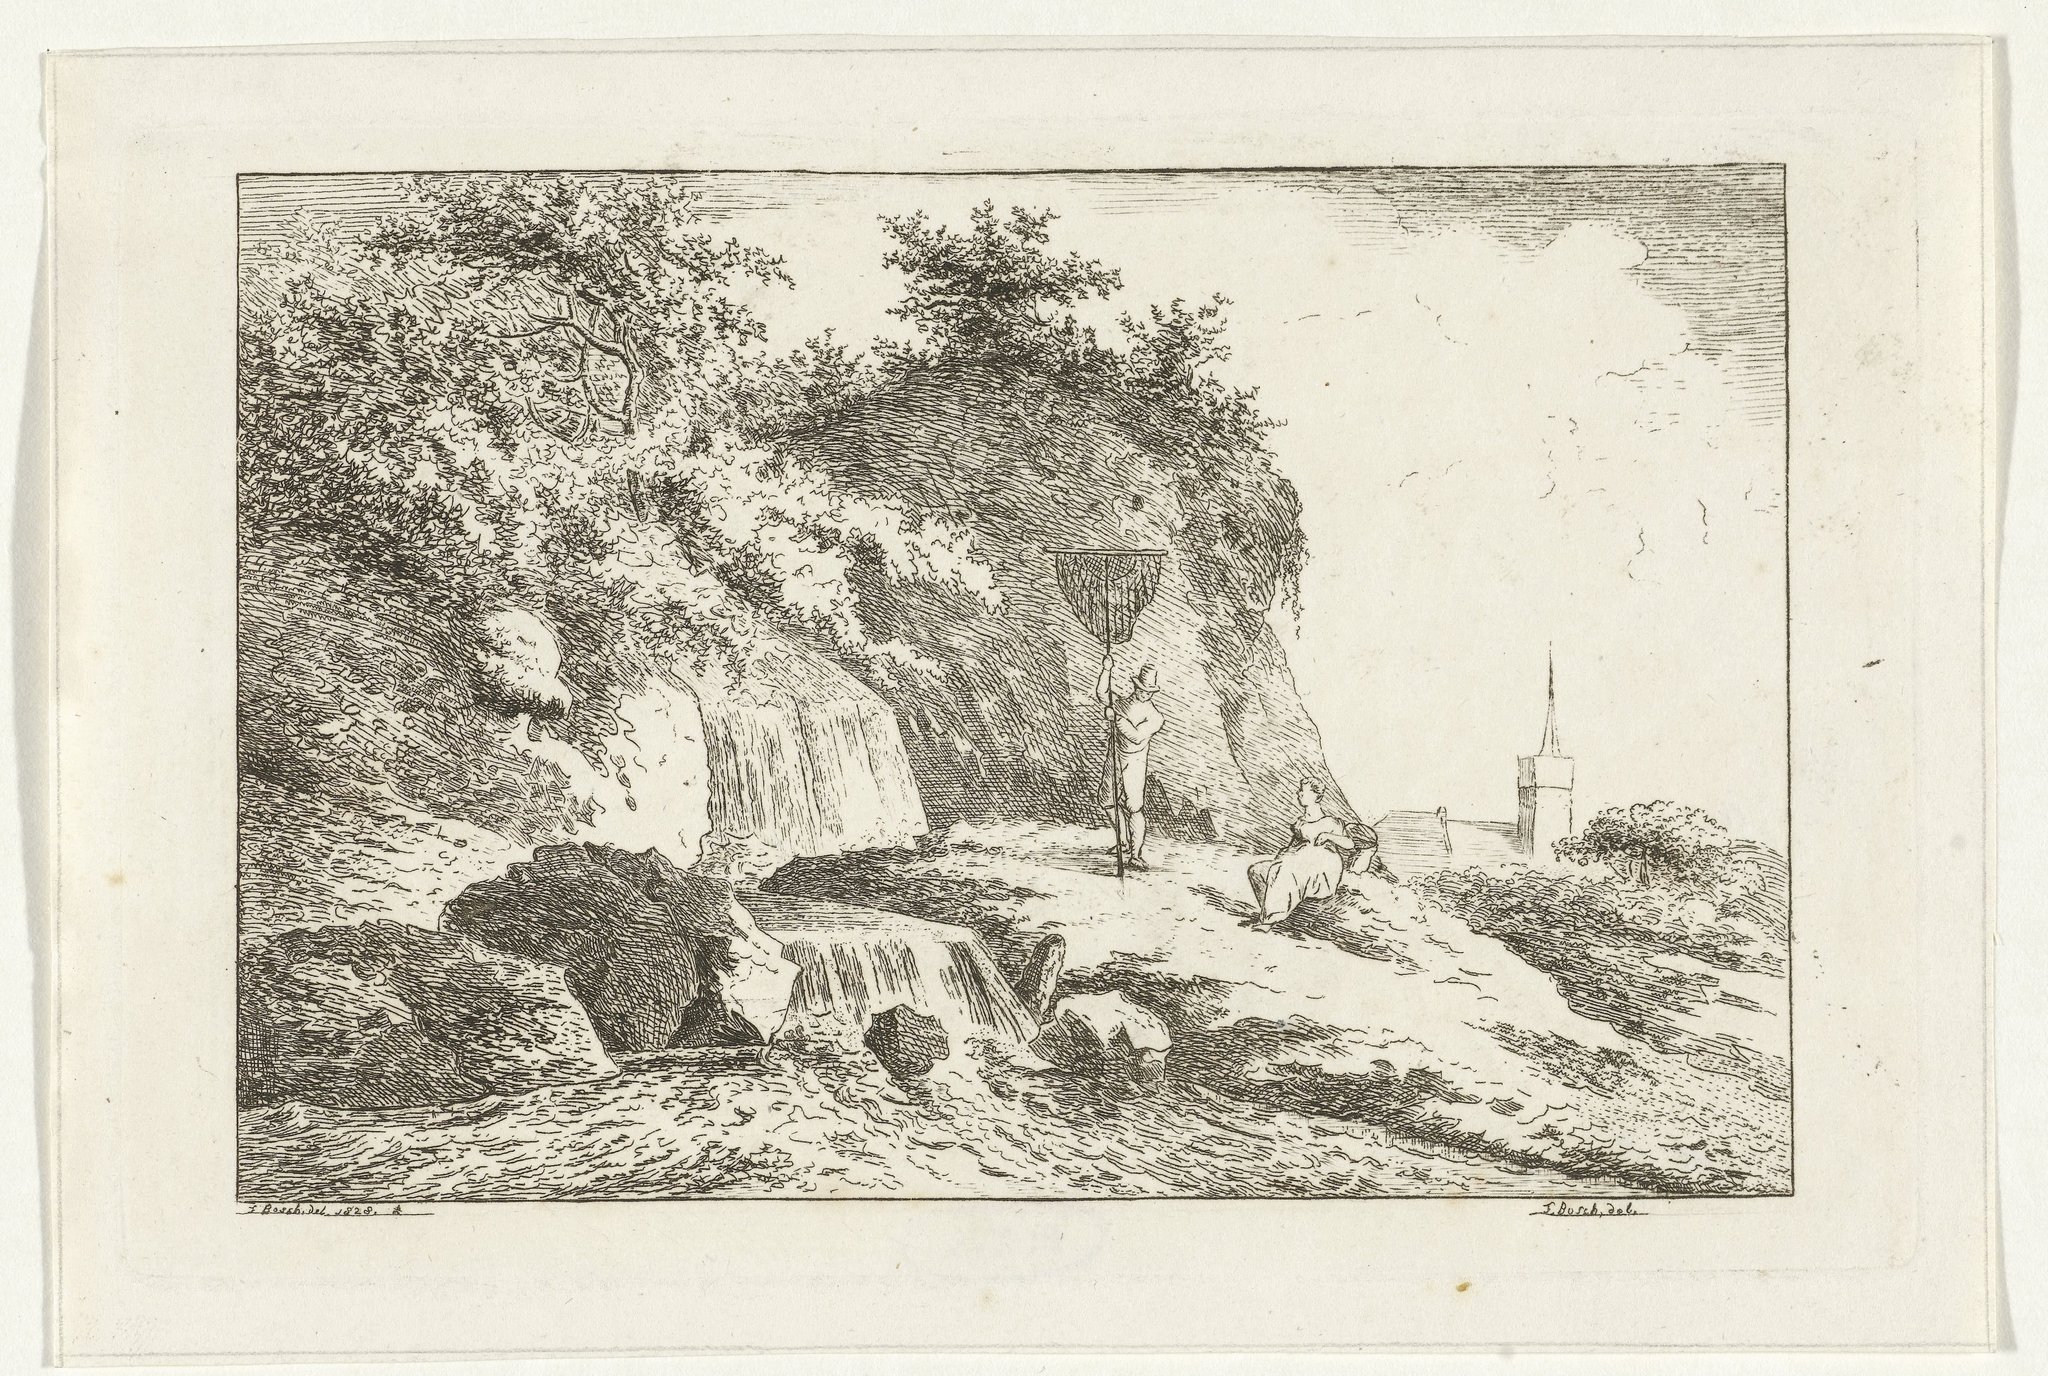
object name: print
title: Landschap met waterval en kerk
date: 1828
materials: paper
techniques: etching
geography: vaassen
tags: waterfall, landscapes (+ landscape with figures, staffage)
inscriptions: collector's mark: Lugt 2228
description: Een staande man, een schepnet in de handen, en een zittende vrouw bij een waterval. Een kerktoren rechtsachter.